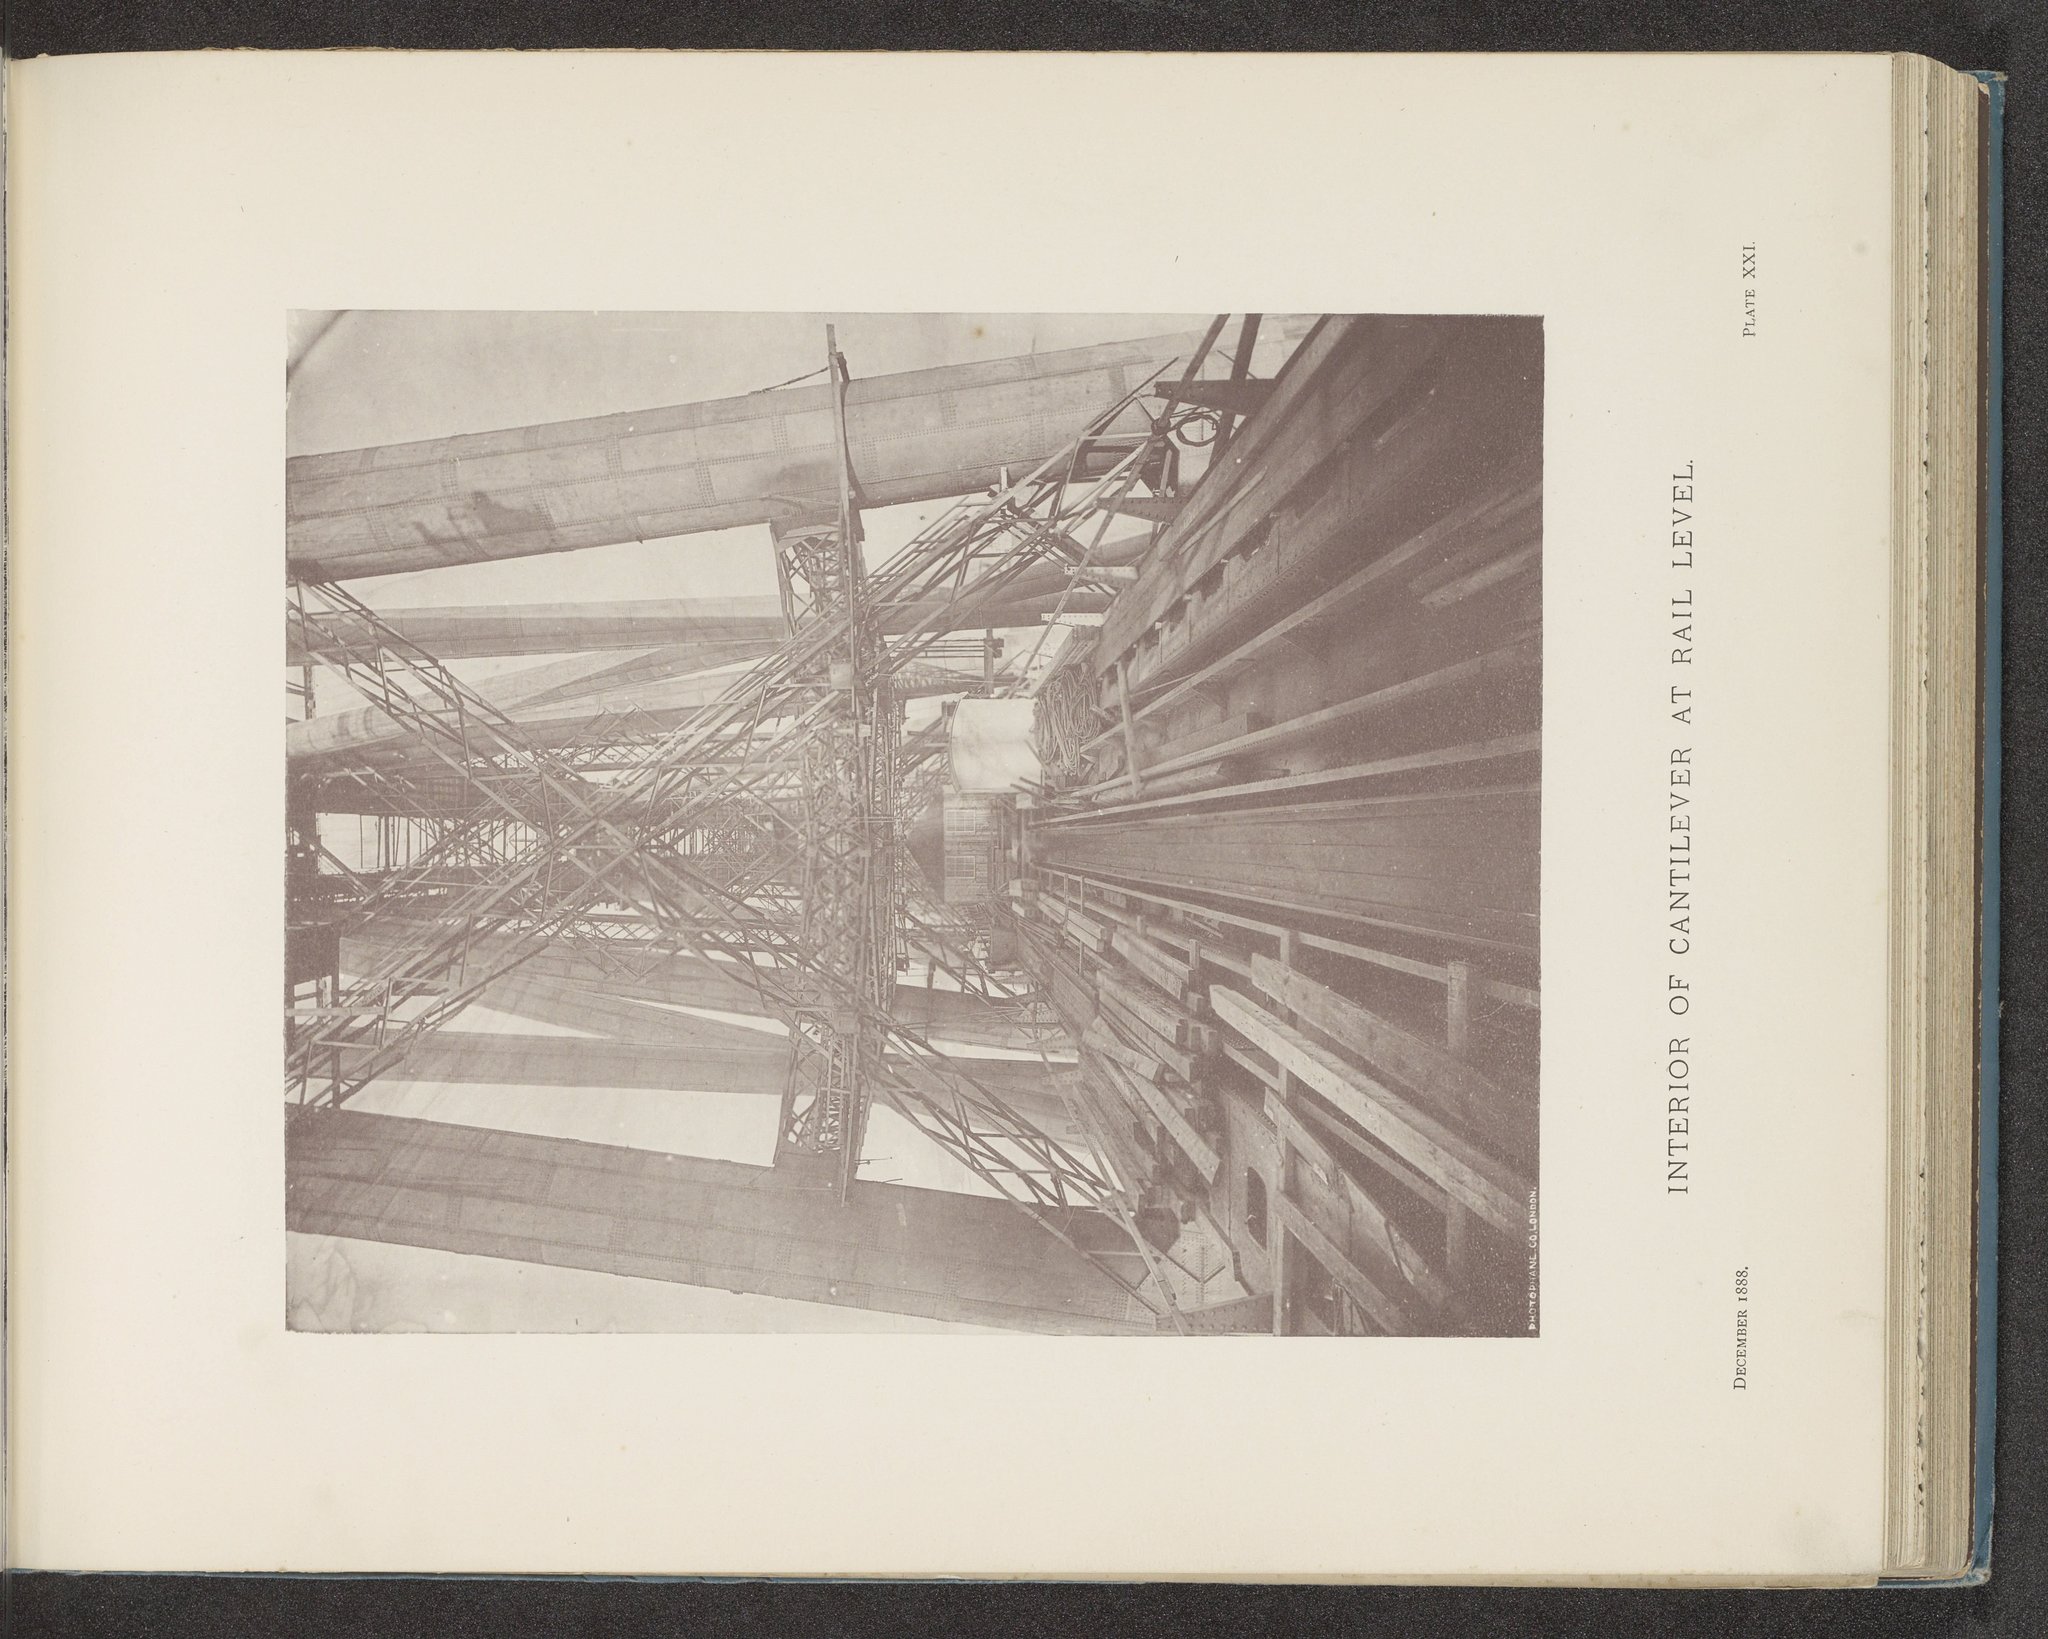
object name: page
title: Interior of cantilever at rail level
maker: Anonymous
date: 1812-1888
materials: paper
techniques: photograph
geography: london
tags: building materials, railway, tramway; rack railway, bridge, building-site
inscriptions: number: ‘Plate XXI.’